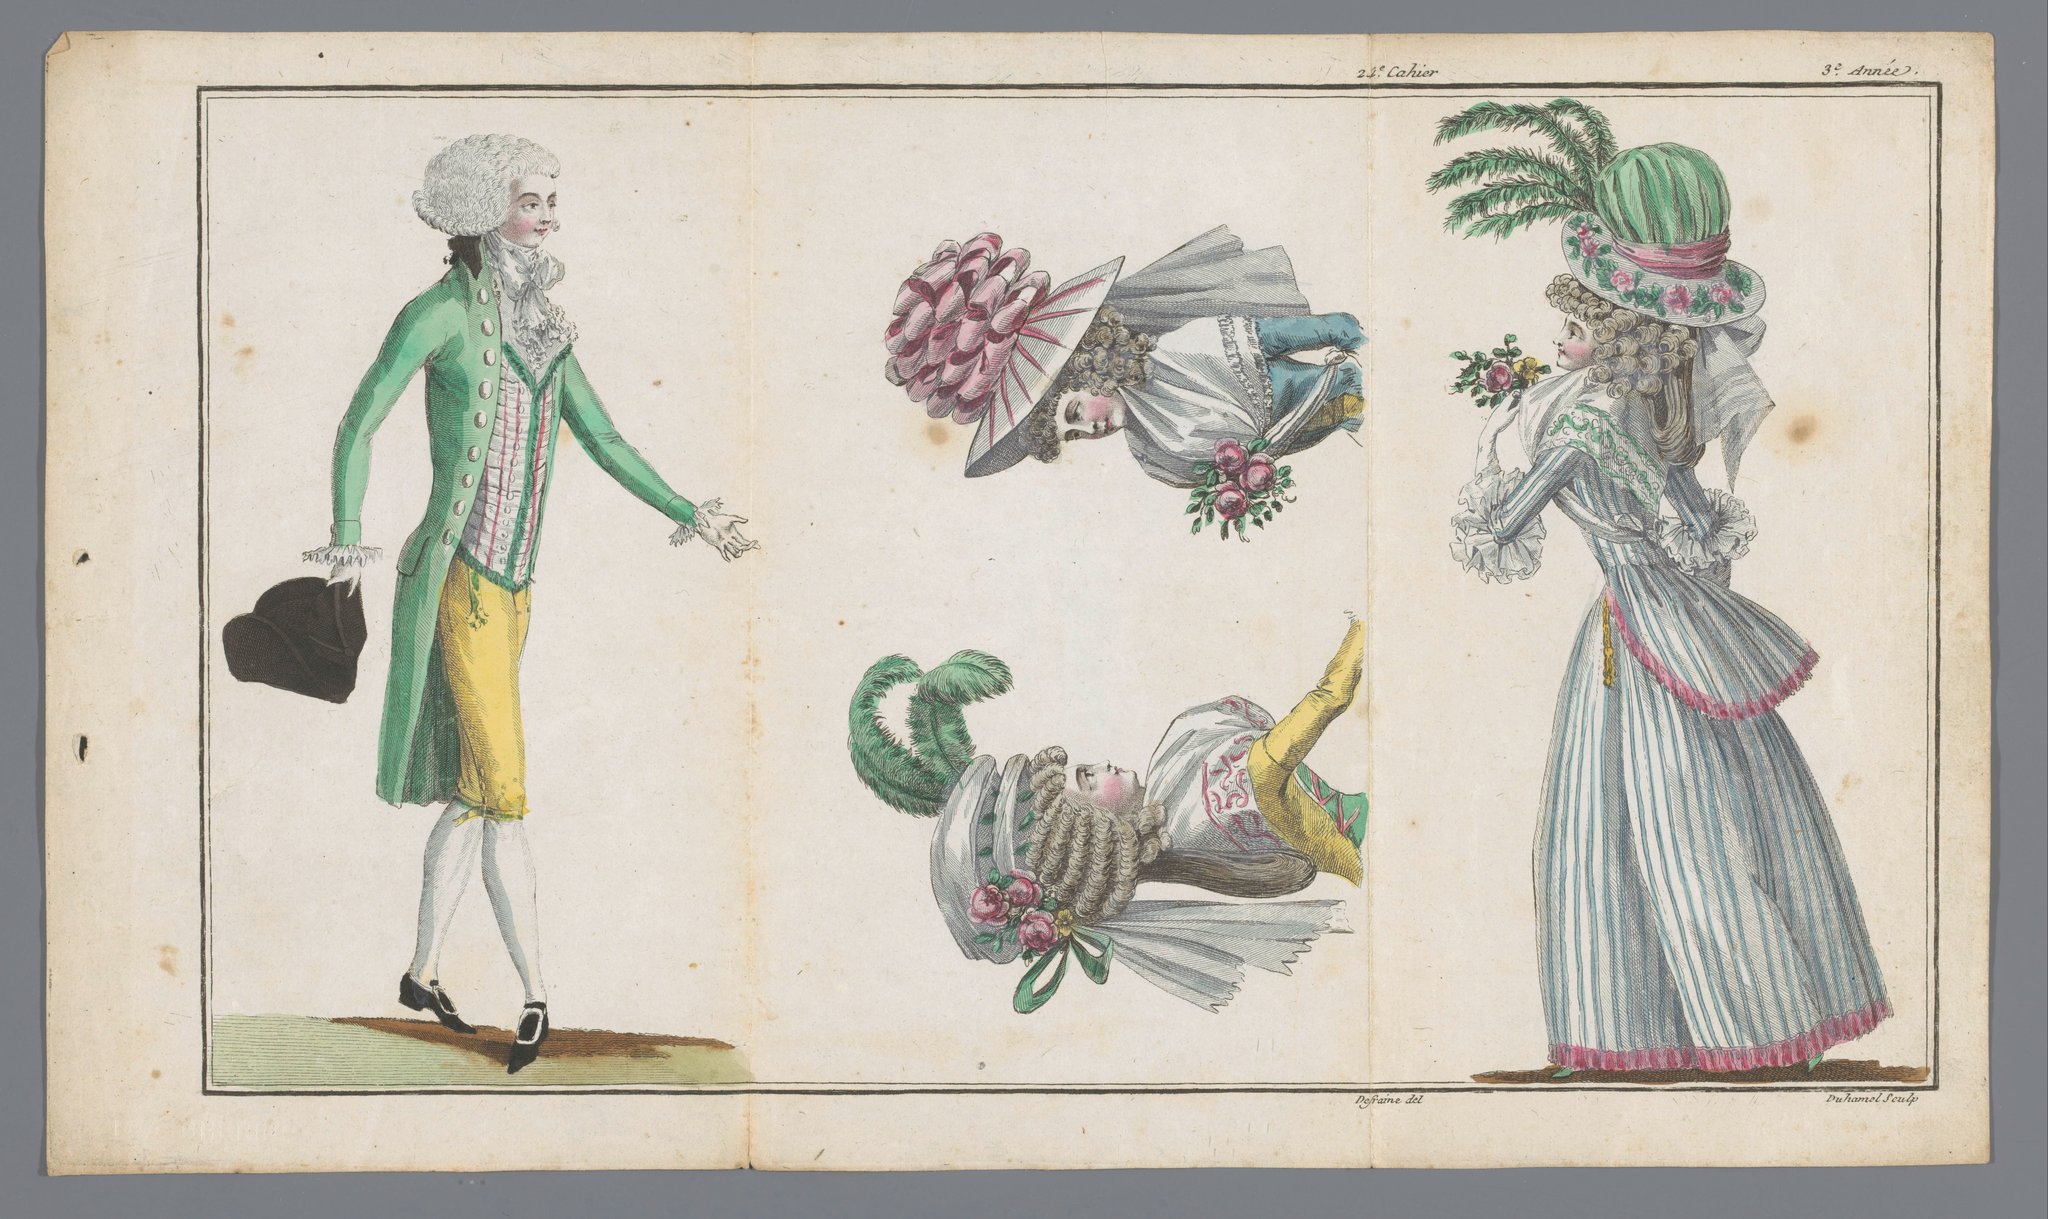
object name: fashion print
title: The First Fashion Magazine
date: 1788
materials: paper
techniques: engraving, hand coloring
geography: paris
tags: clothing for the upper part of the body (vest) (+ men's clothes), clothing for the upper part of the body (caraco) (+ women's clothes), head-gear, head-gear (pouf) (+ women's clothes), coat (+ men's clothes), head-gear (chapeau à la jockey) (+ women's clothes), fashion plates, skirt (+ women's clothes), dress, gown (+ women's clothes), trousers, breeches, etc. (breeches) (+ men's clothes)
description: The Cabinet des Modes ou les Modes Nouvelles first appeared on 15 November 1785. As the first real fashion magazine, it was published on a regular basis and wholly dedicated to news from the world of fashion. It was available by subscription only and distributed both in France and abroad. Each eight-page edition contained three hand-coloured engravings. After a year in print, the magazine changed its name to Magasin des Modes Nouvelles Françaises et Anglaises. Instead of three loose sheets, it now included a single fold-out plate depicting clothes and accessories. Publication of the Magasin ceased abruptly in 1789; after this, it was most likely succeeded by the Journal de la Mode et du Goût.